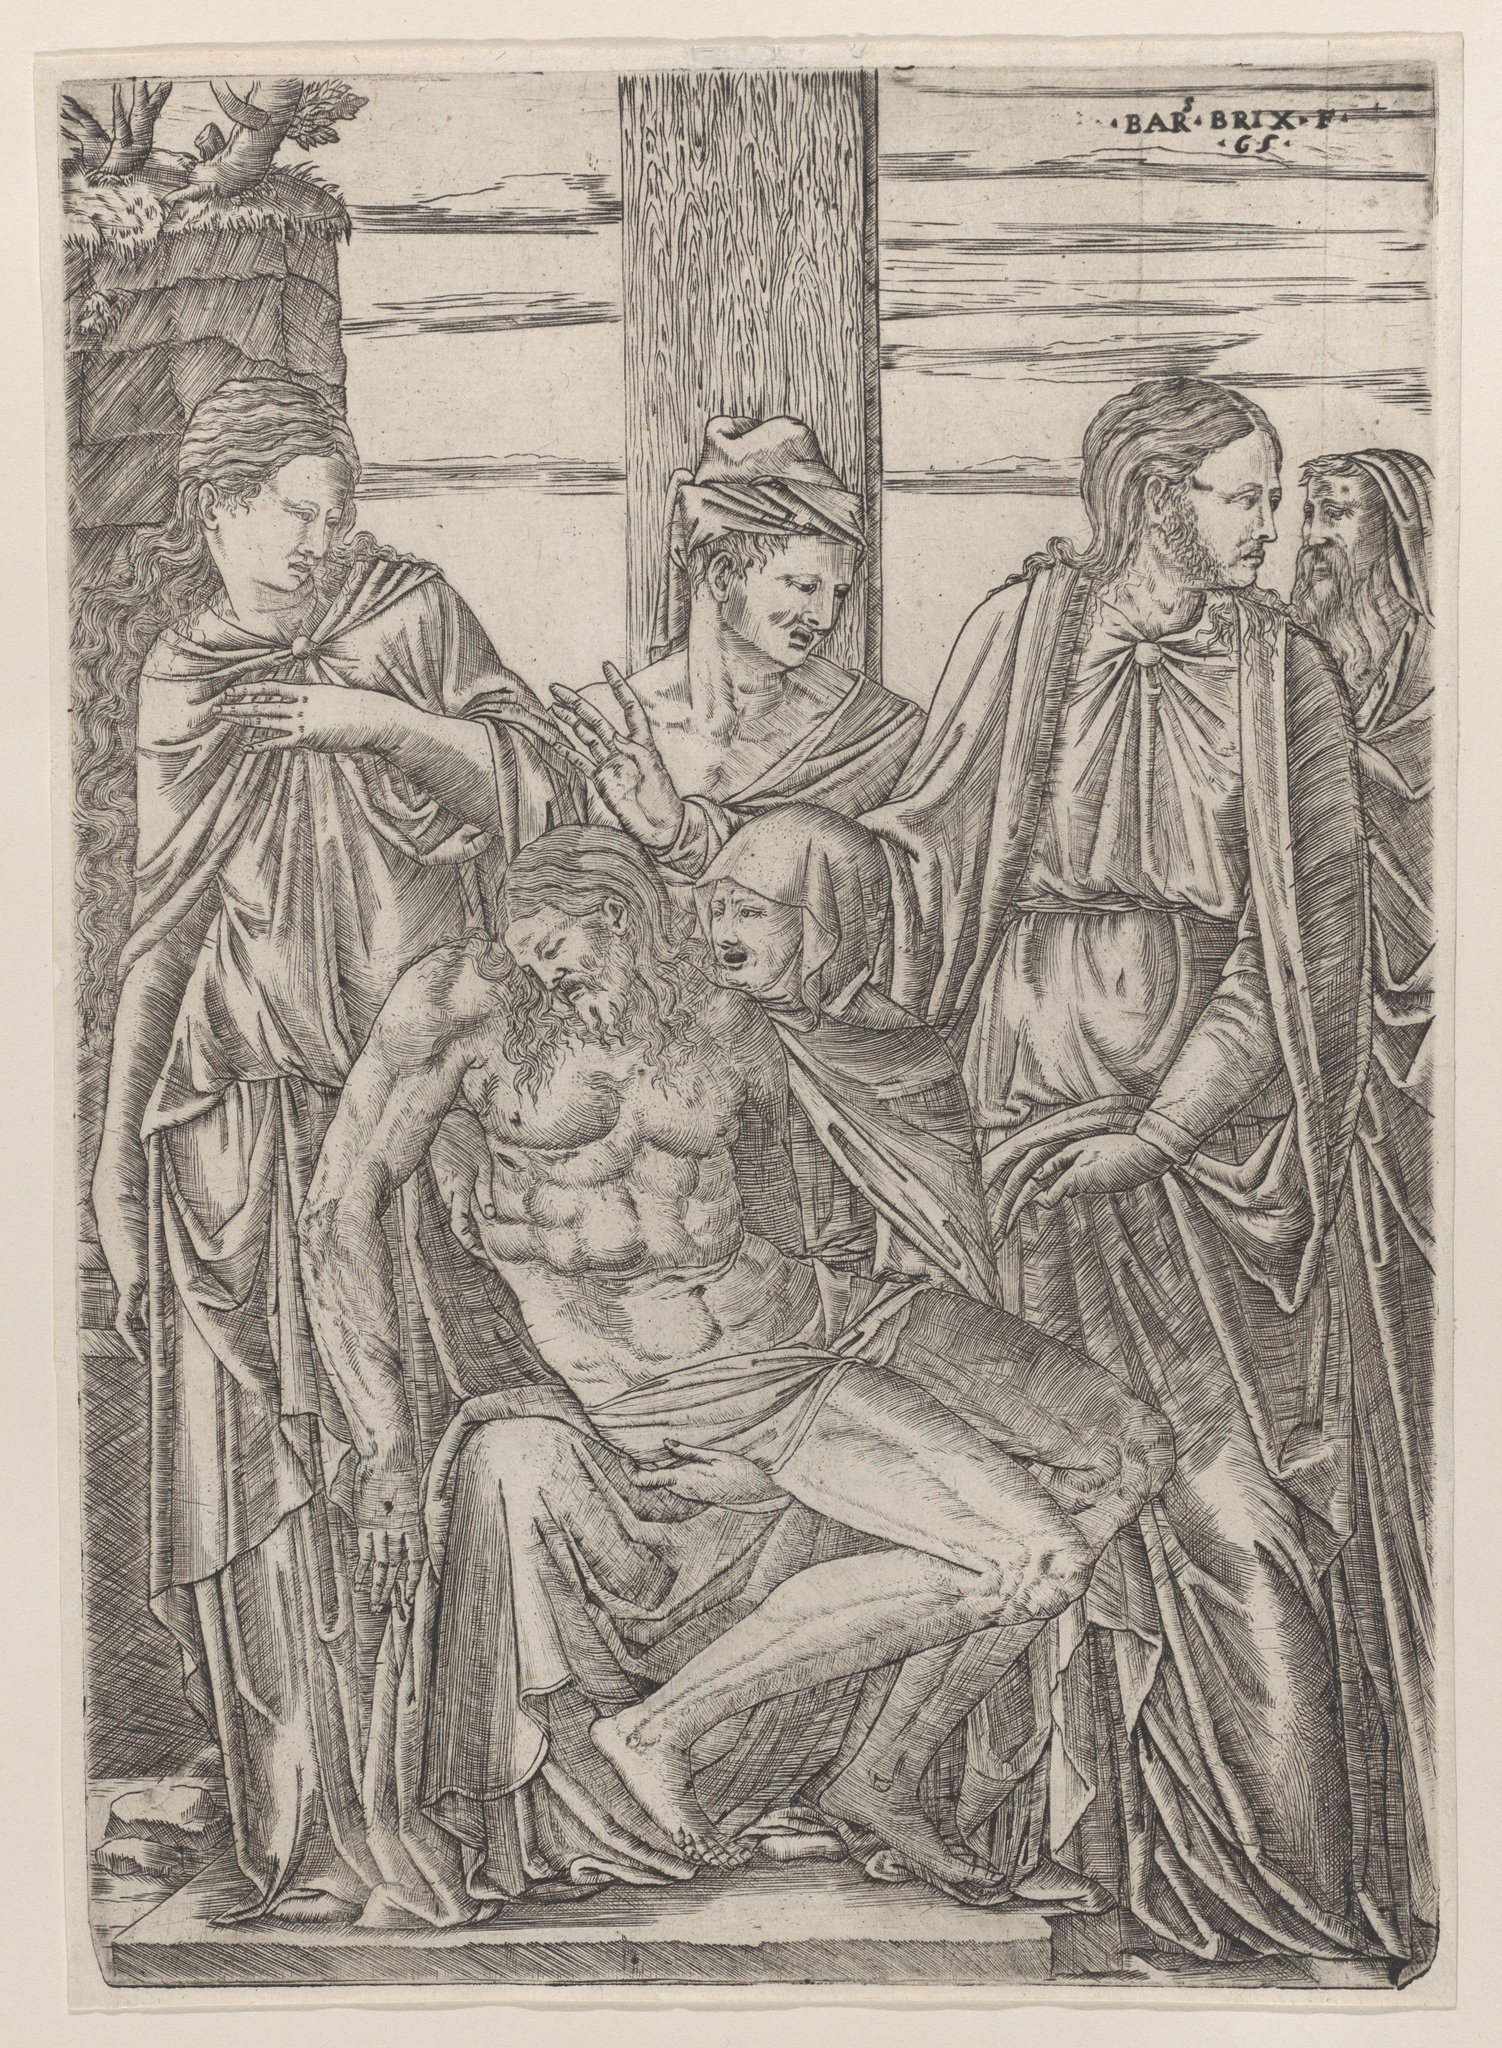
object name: print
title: The descent from the cross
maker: bartolomeo da brescia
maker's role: artist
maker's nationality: italian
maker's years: 1570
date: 1565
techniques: engraving